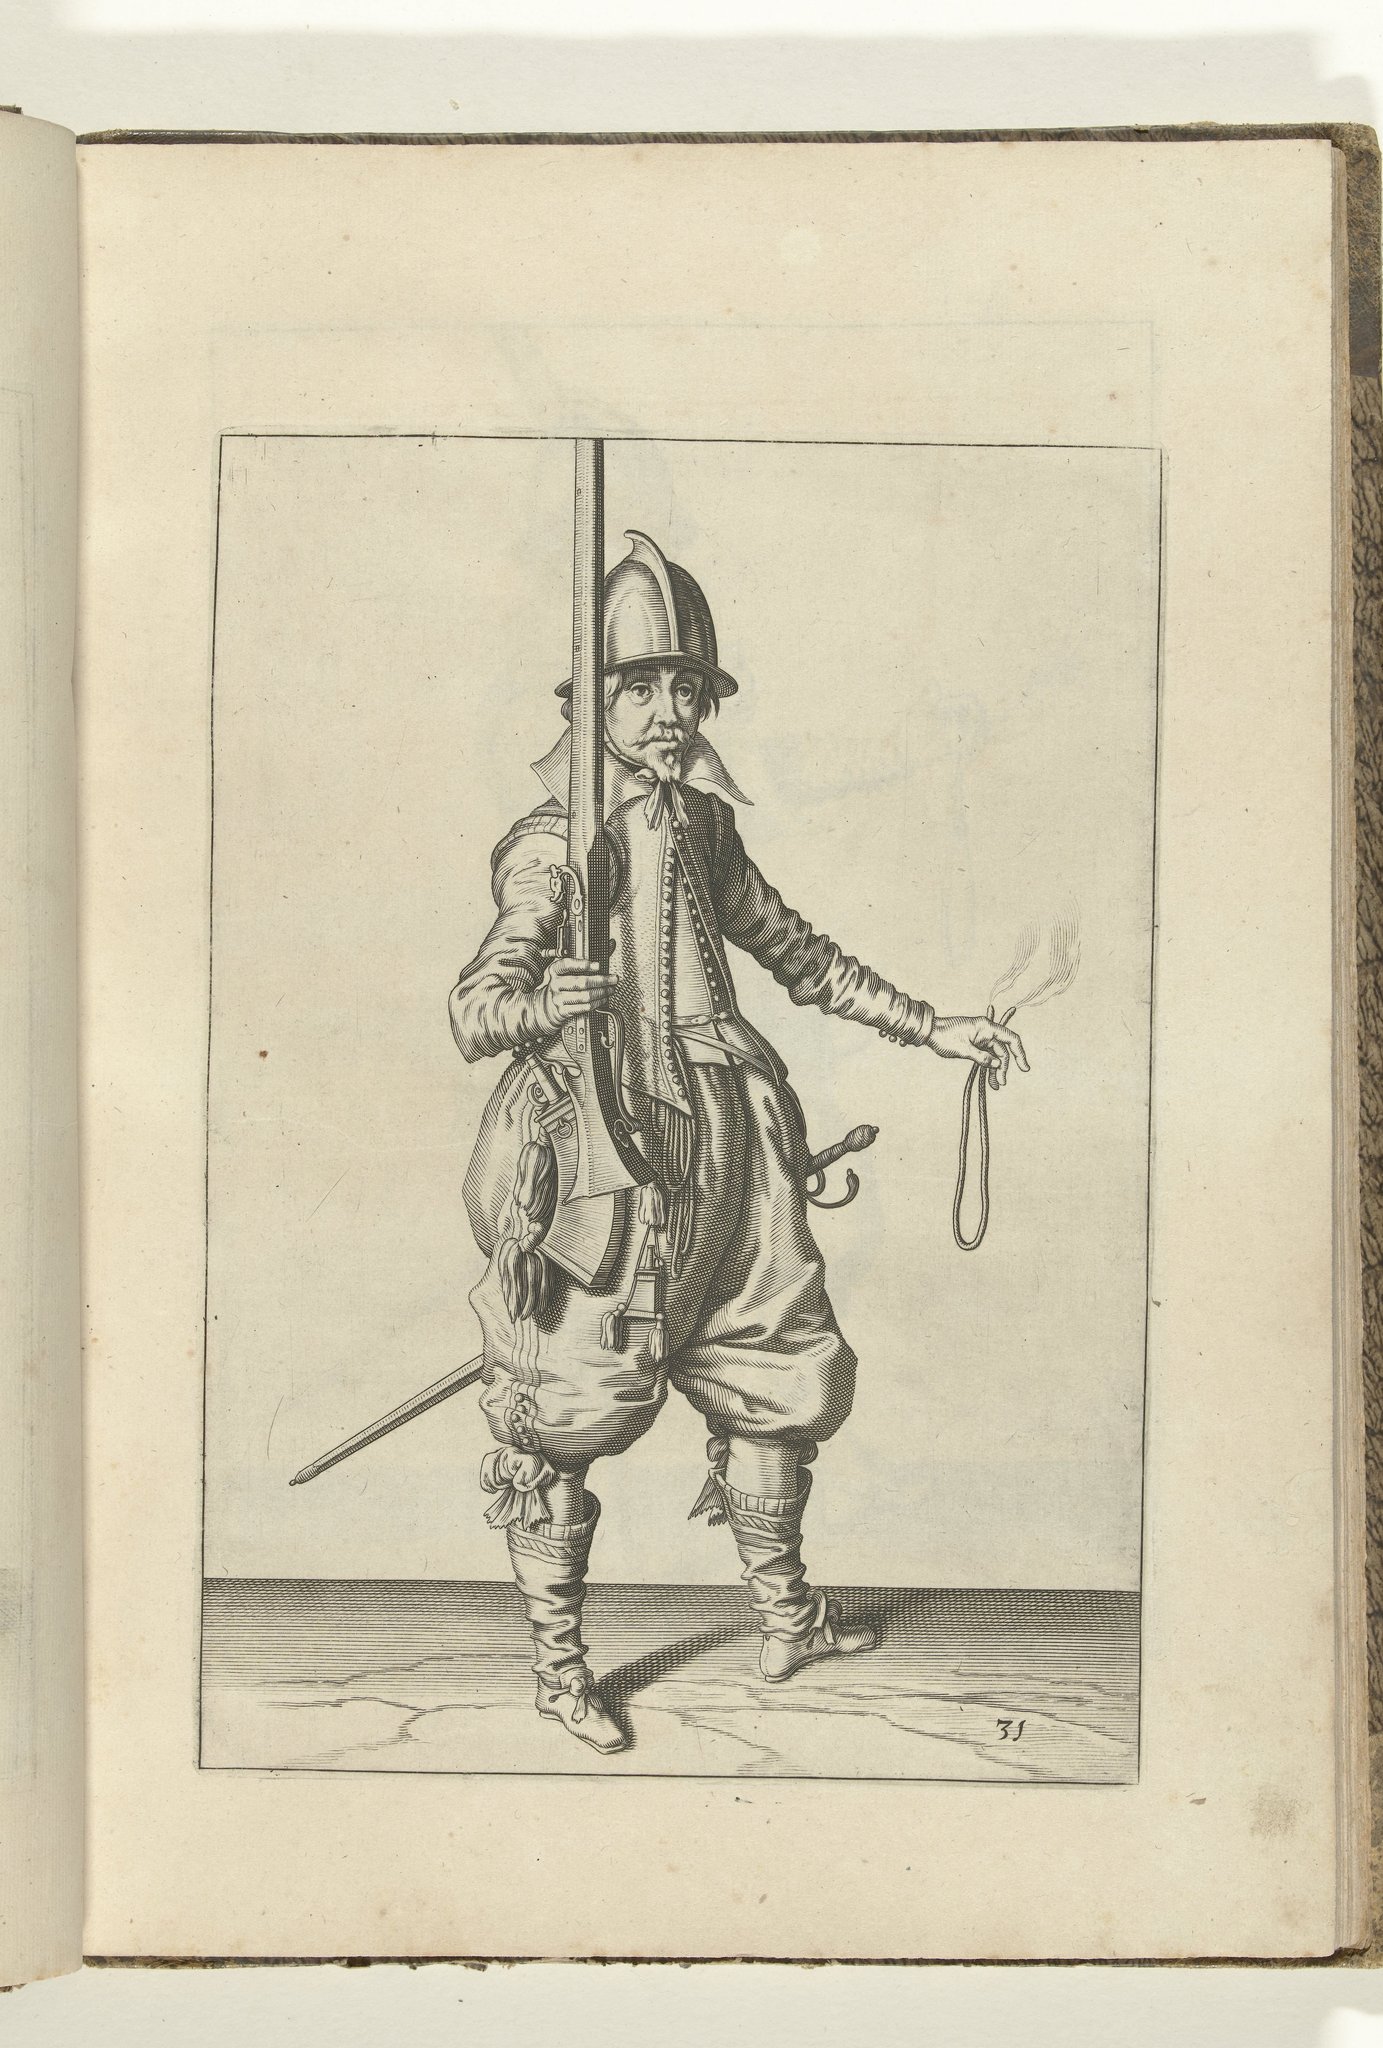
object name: print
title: Soldaat die zijn roer met zijn rechterhand rechtop vasthoudt (nr. 31), ca. 1600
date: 1597-1608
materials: paper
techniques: engraving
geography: amsterdam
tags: the hague, maurice (prince of orange), handling of weapons ~ military training, weapons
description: Een soldaat, ten voeten uit, naar rechts, die een roer (een bepaald type vuurwapen) met zijn rechterhand vasthoudt, de loop omhoog wijzend, alvorens het wapen op zijn linkerschouder te leggen (nr. 31), ca. 1600. In zijn uitgestoken linkerhand een brandende lont. Plaat 31 in de instructies voor het hanteren van de roer: Brief enseignement, sur la representation des figures, du droit maniement de l'Harquebuse. Onderdeel van de illustraties in een Franse editie van J. de Gheyns Wapenhandelinghe: J. de Gheyn, Maniement d'armes, d'arquebuses, mousquetz et piques : en conformité de l'ordre de Mour le Prince Maurice, Prince d'Orange, Amsterdam 1608. Krijgswezen rond 1600.